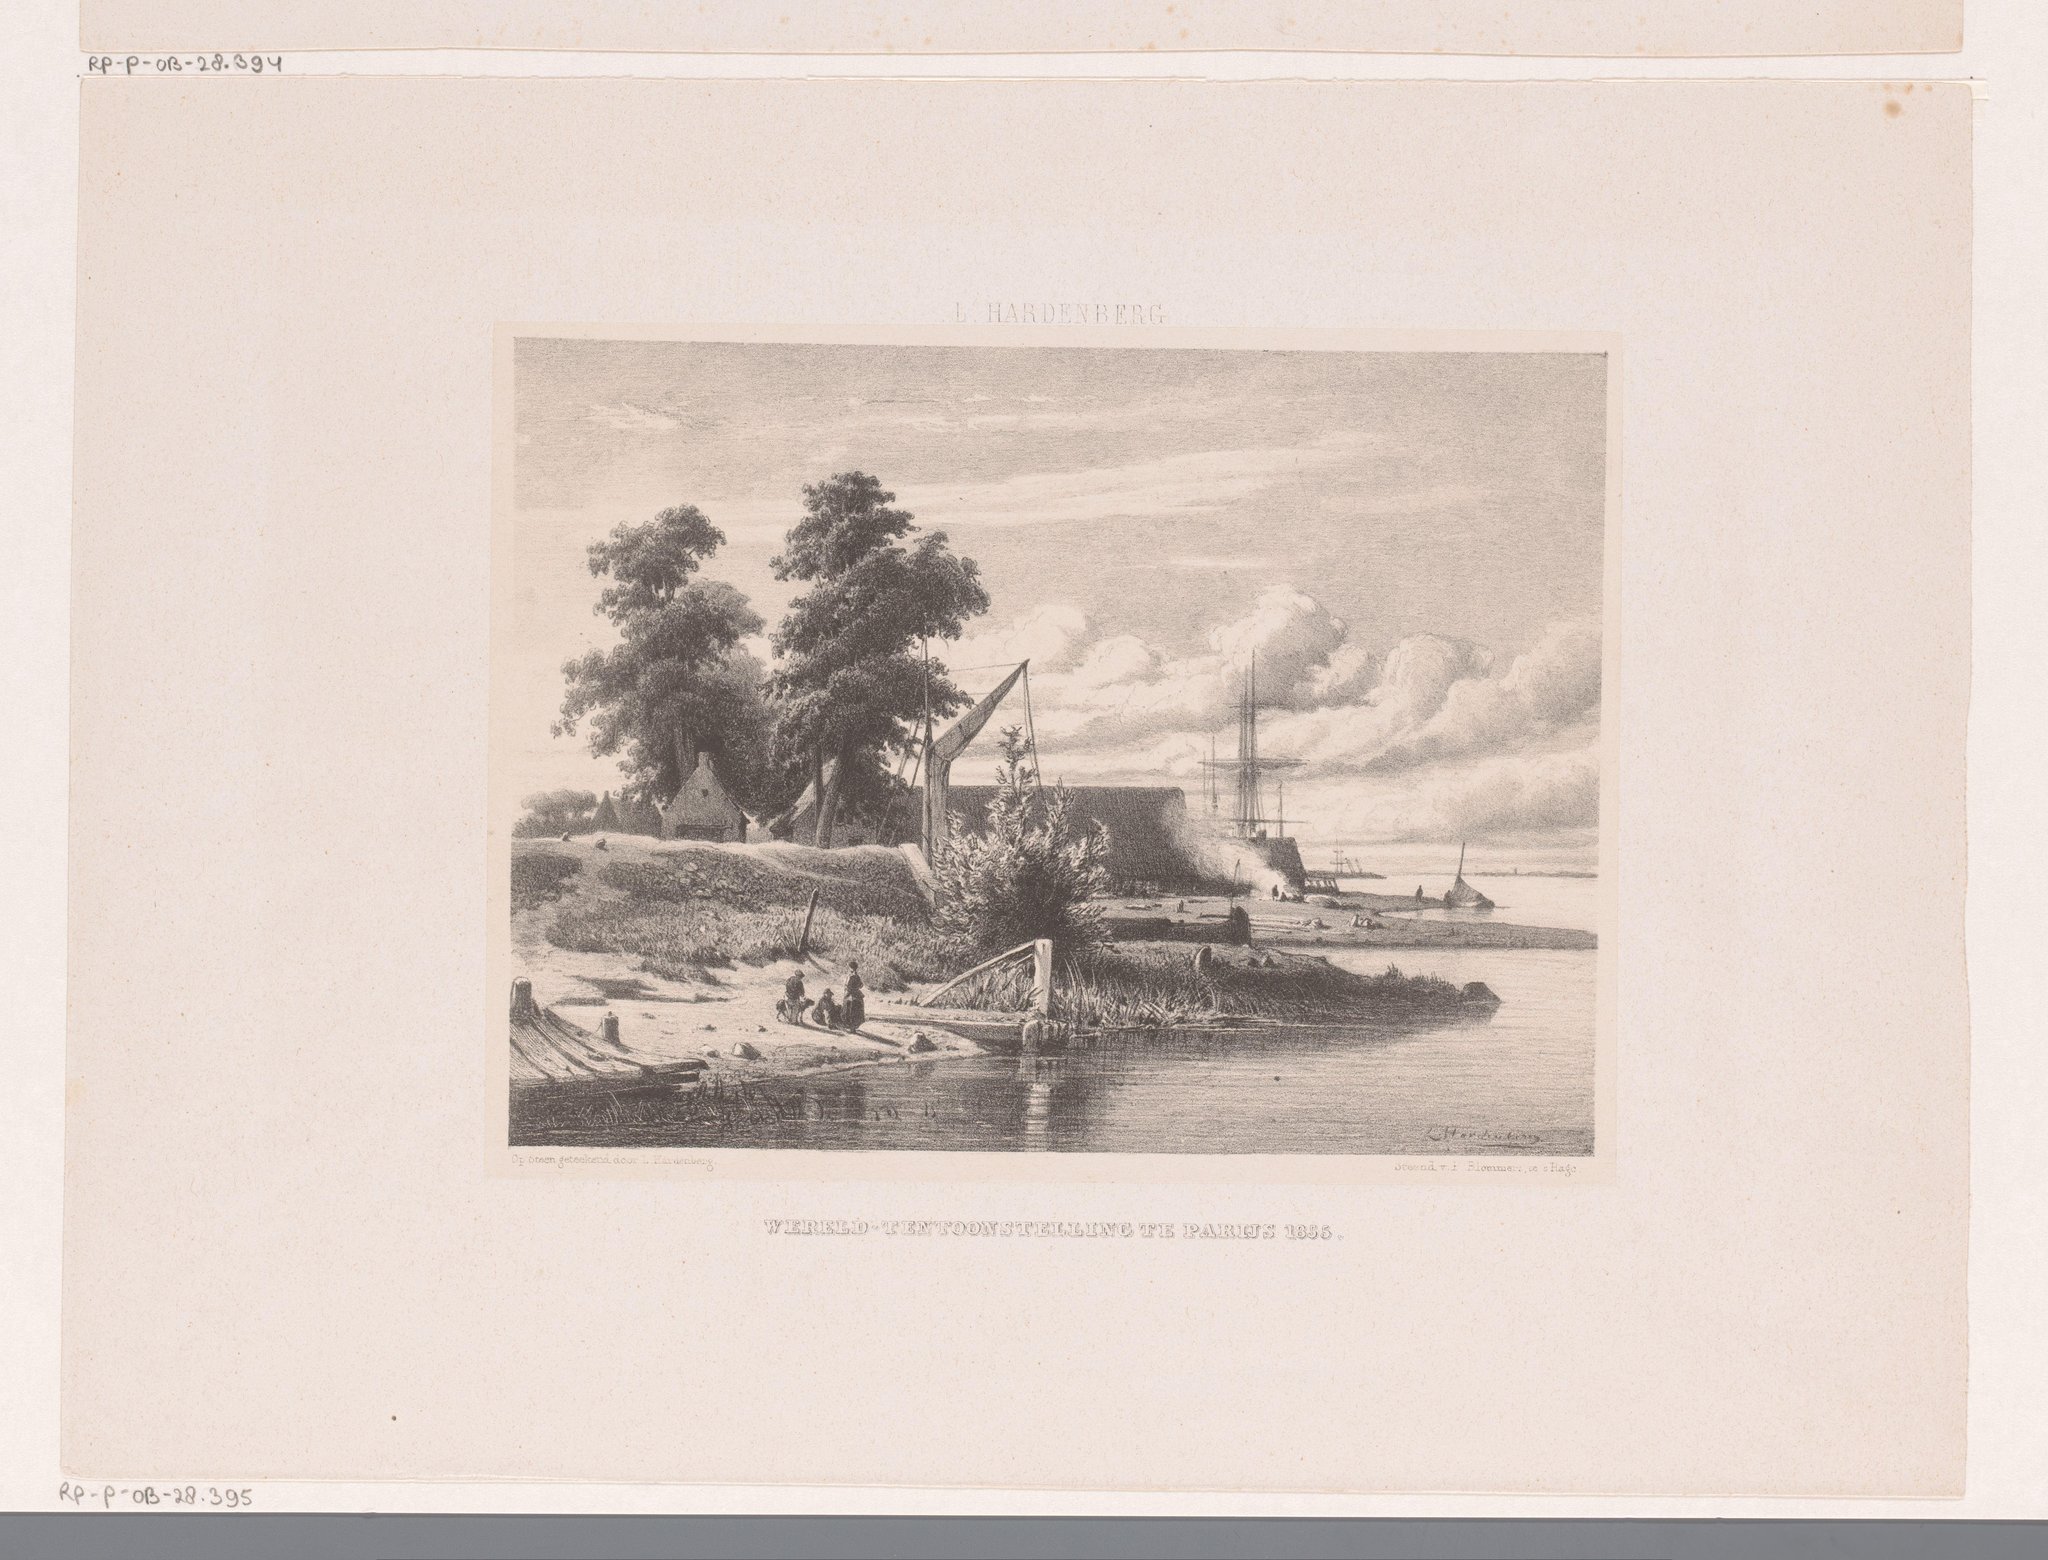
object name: print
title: Riviergezicht aan de Maas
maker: lambertus hardenberg (1822-1900)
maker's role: draughtsman, painter, print maker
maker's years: 1822-1900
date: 1855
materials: paper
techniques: lithograph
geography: the hague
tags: sailing-ship, sailing-boat, river bank, pier, quay, wharf, river (+ landscape with figures, staffage)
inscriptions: date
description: Op de oever liggen aanlegsteigers, verderop staan huizen. Achter bomen en huizen steken masten en zeilen van zeilschepen uit.